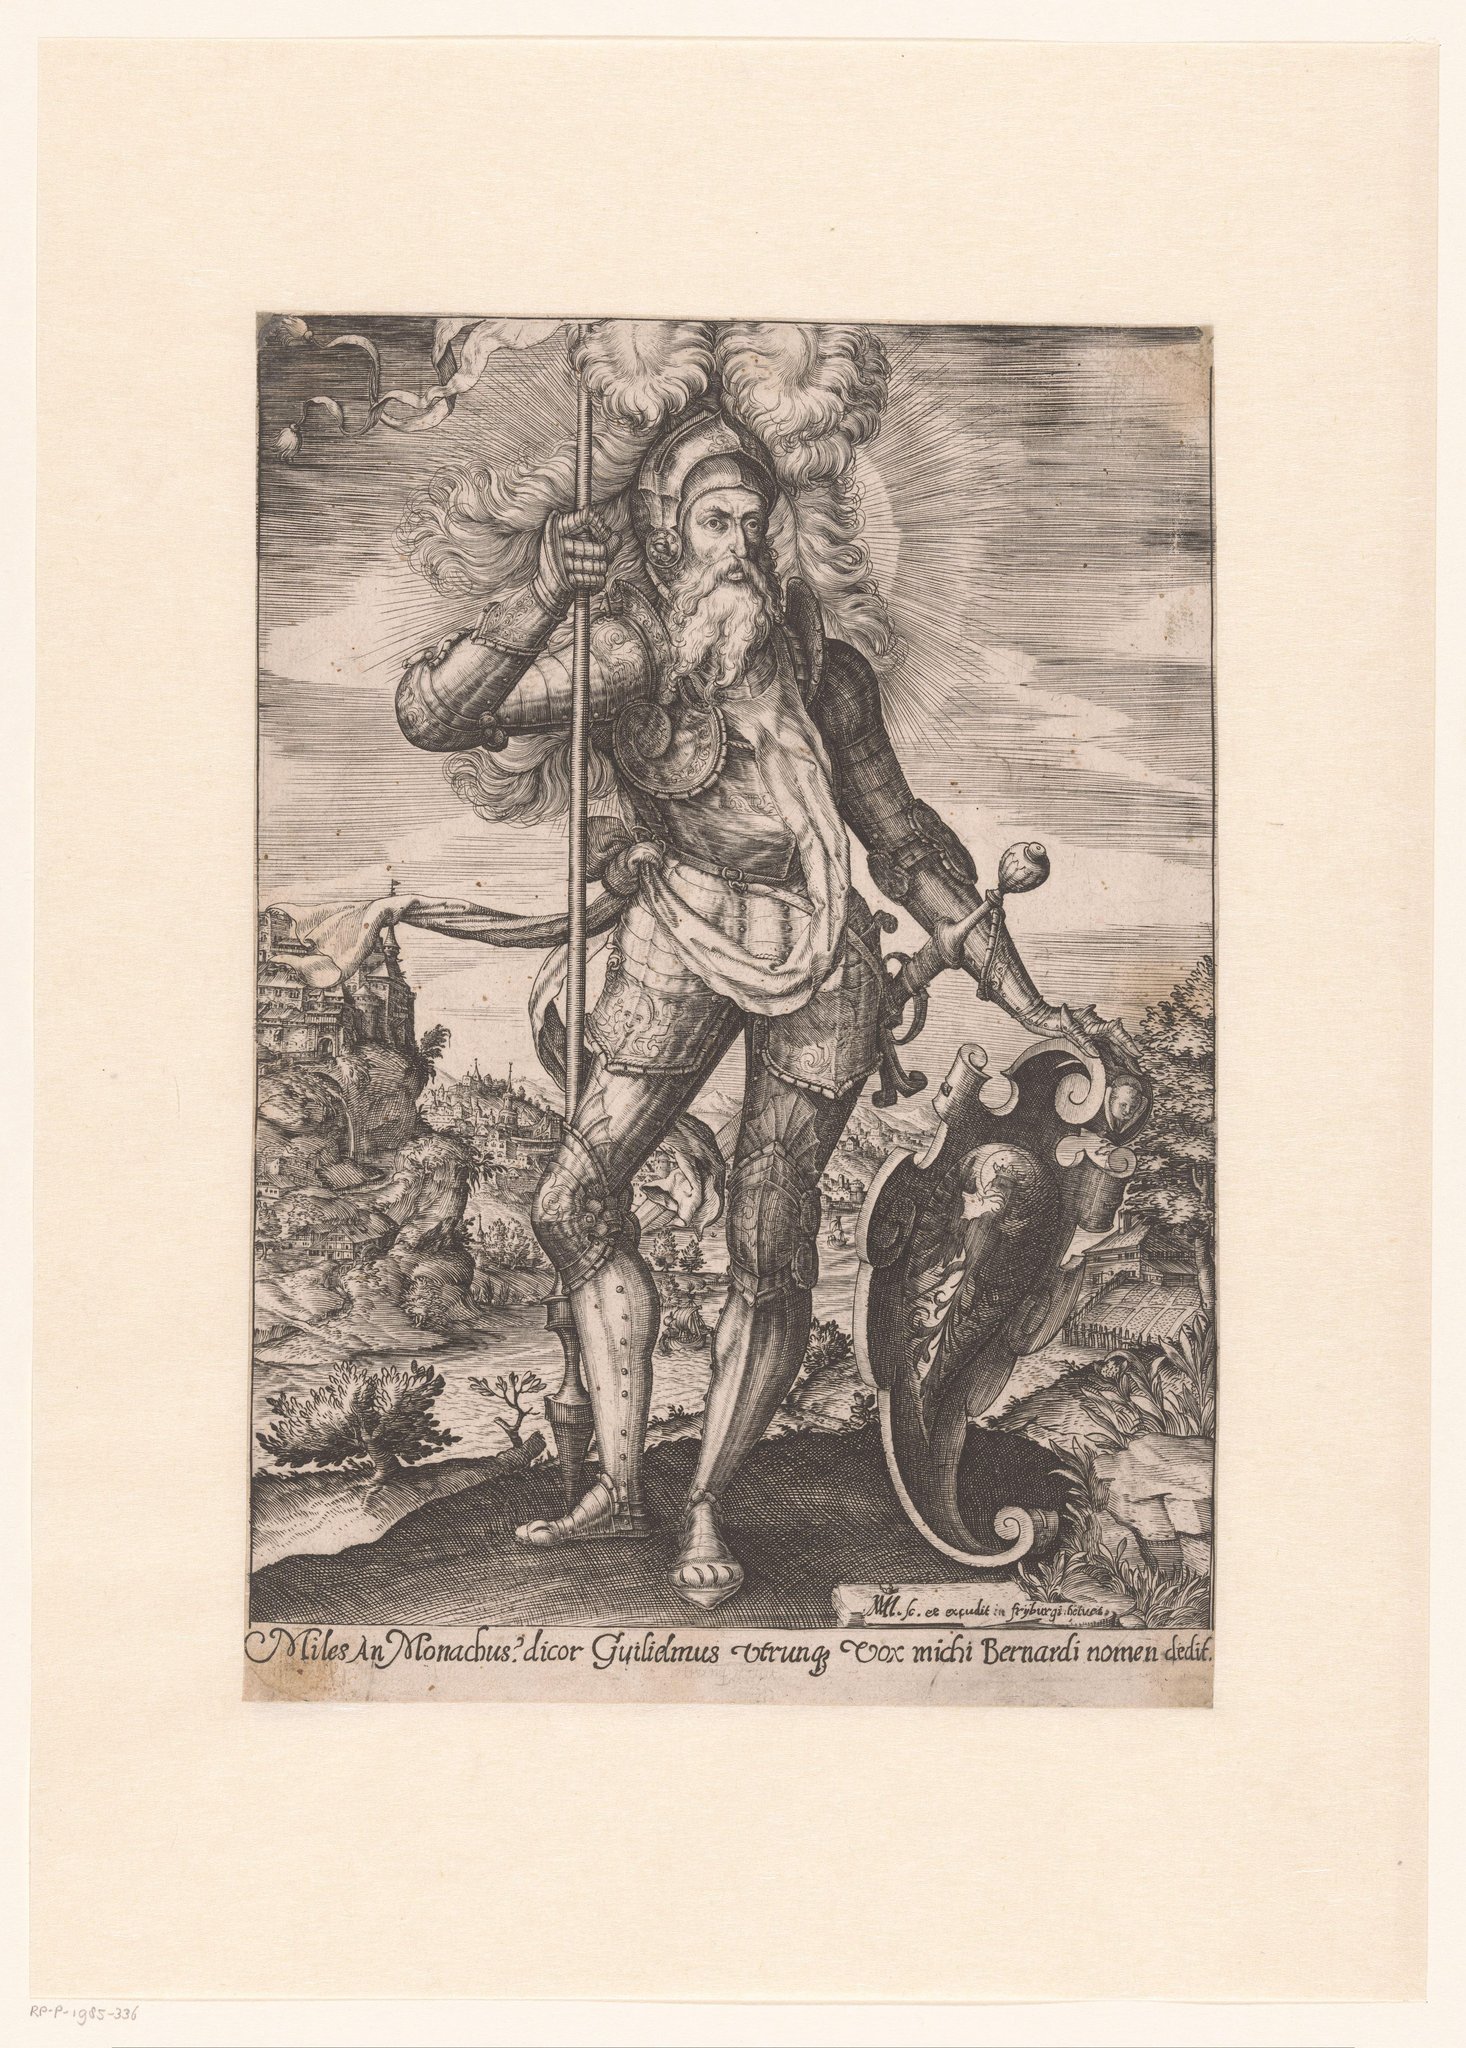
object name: print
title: Heilige Willem van Aquitanië als ridder in een landschap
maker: martin martini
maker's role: print maker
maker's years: 1566-1610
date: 1576-1610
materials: paper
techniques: engraving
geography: fribourg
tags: the benedictine monk and duke of aquitaine, william (of gellone); possible attributes: armour, banner, helmet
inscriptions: collector's mark: Lugt 2760, collector's mark: Lugt 2228